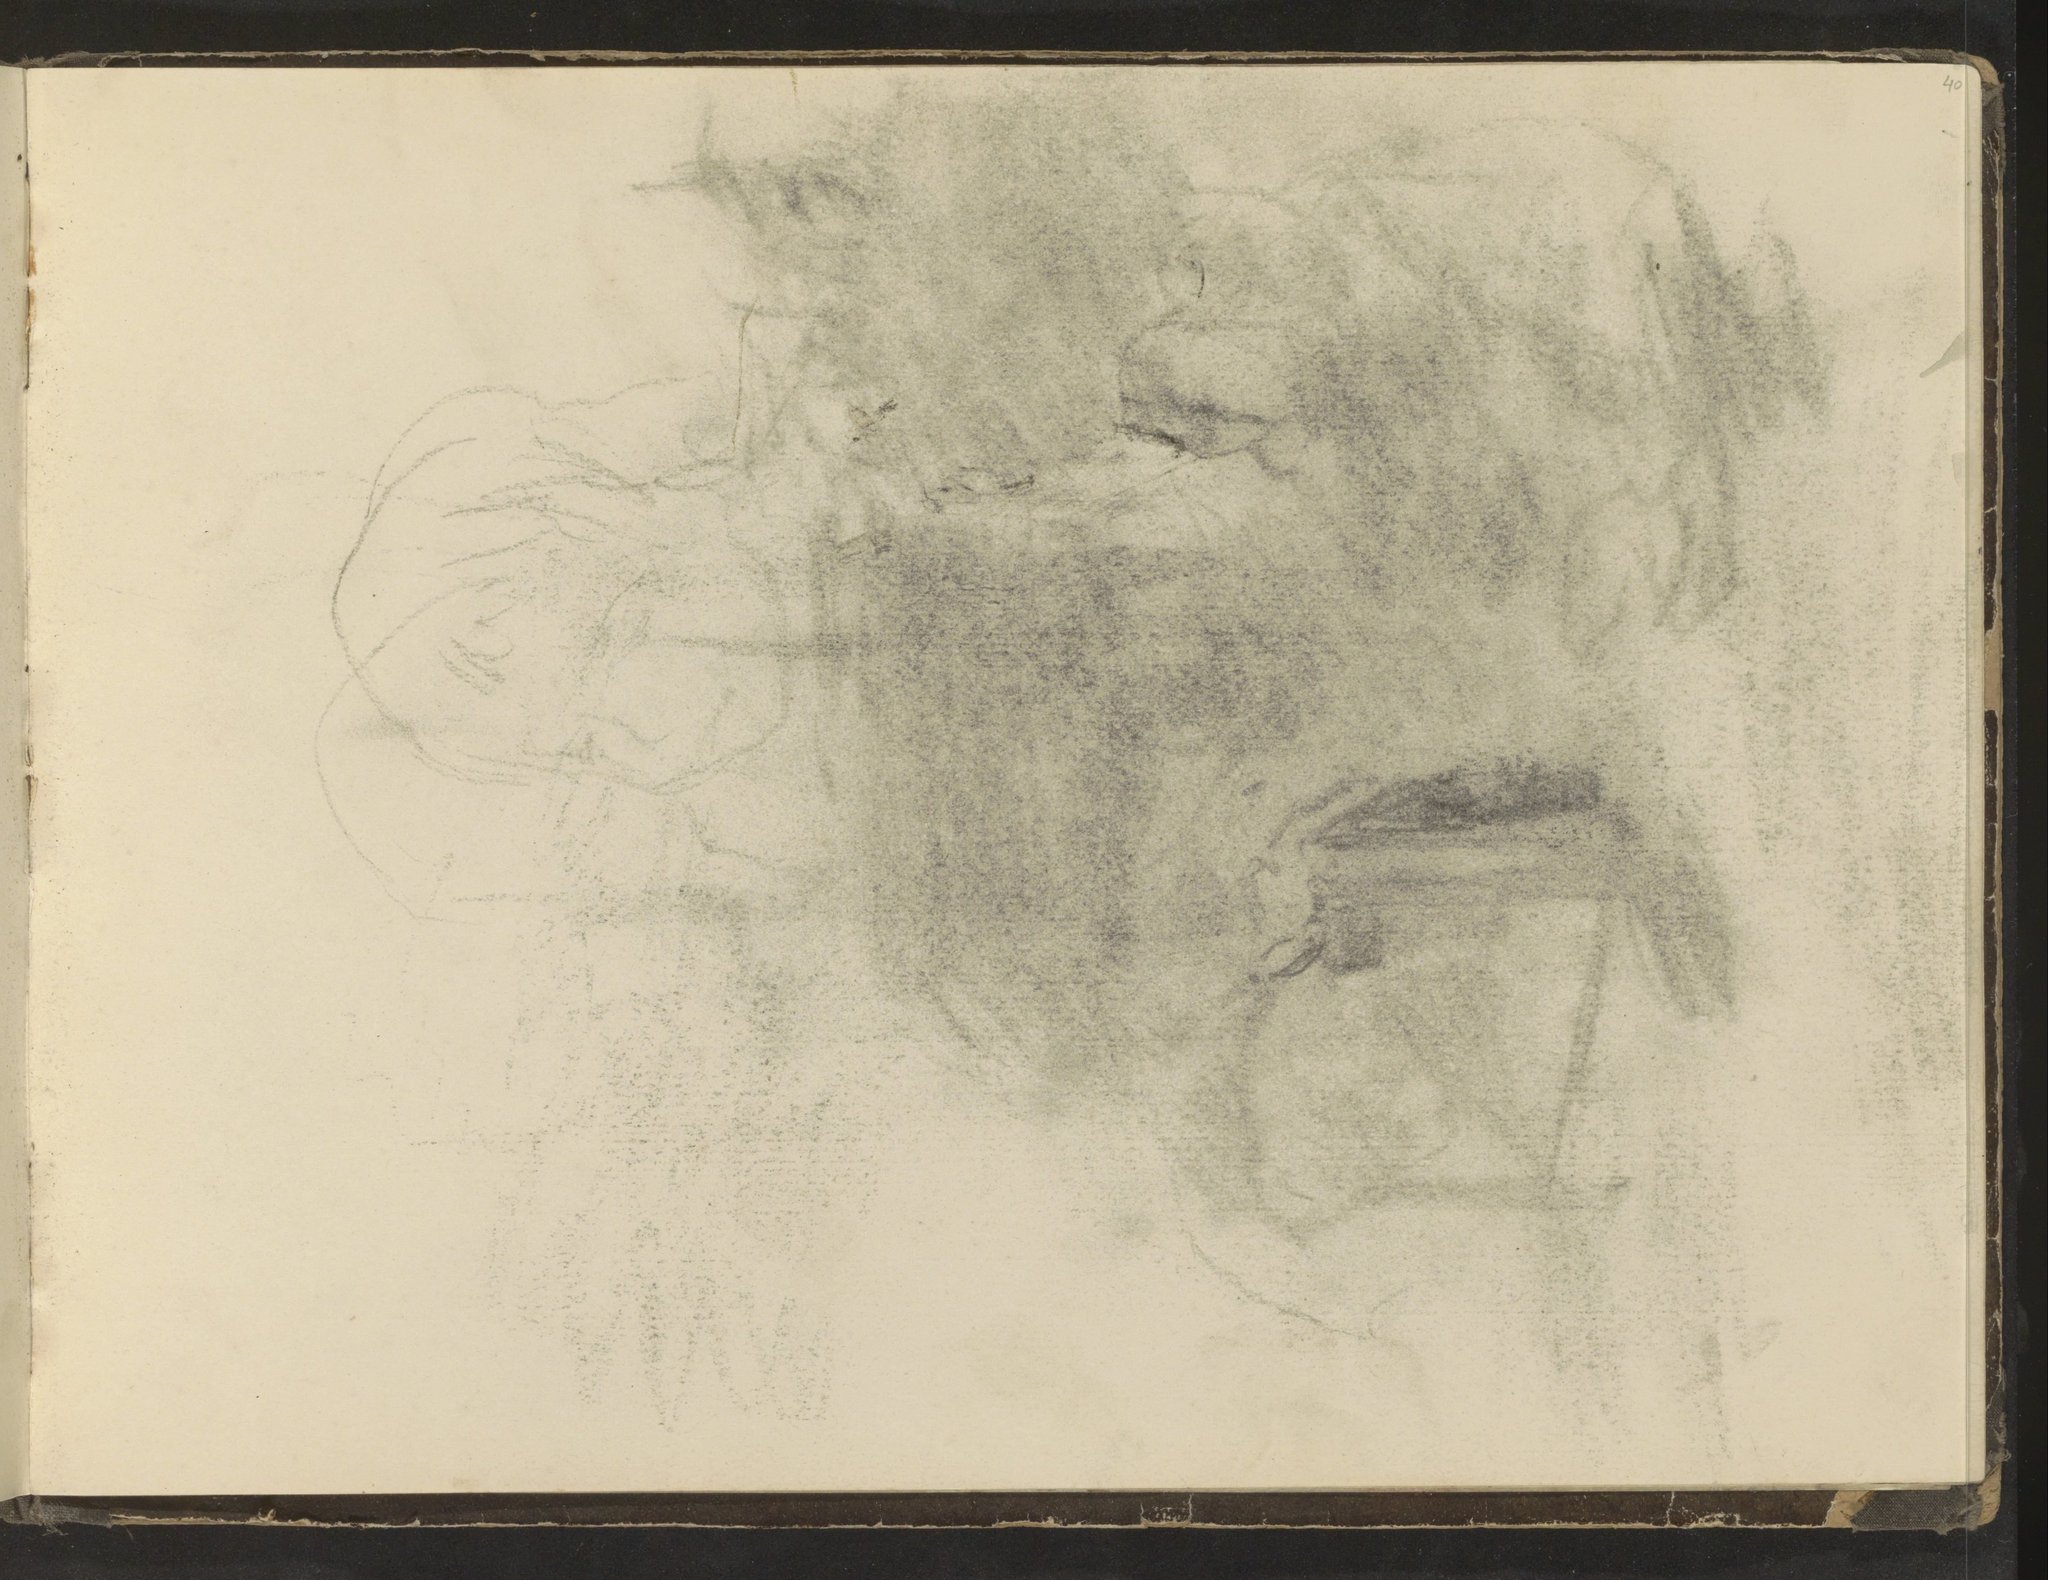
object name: sketchbook leaf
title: Landschap met bomen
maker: albert neuhuys (1844-1914)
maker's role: draughtsman, painter, print maker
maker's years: 1844-1914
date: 1854-1914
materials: charcoal, paper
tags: trees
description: Blad 40 recto uit een schetsboek met 43 bladen.